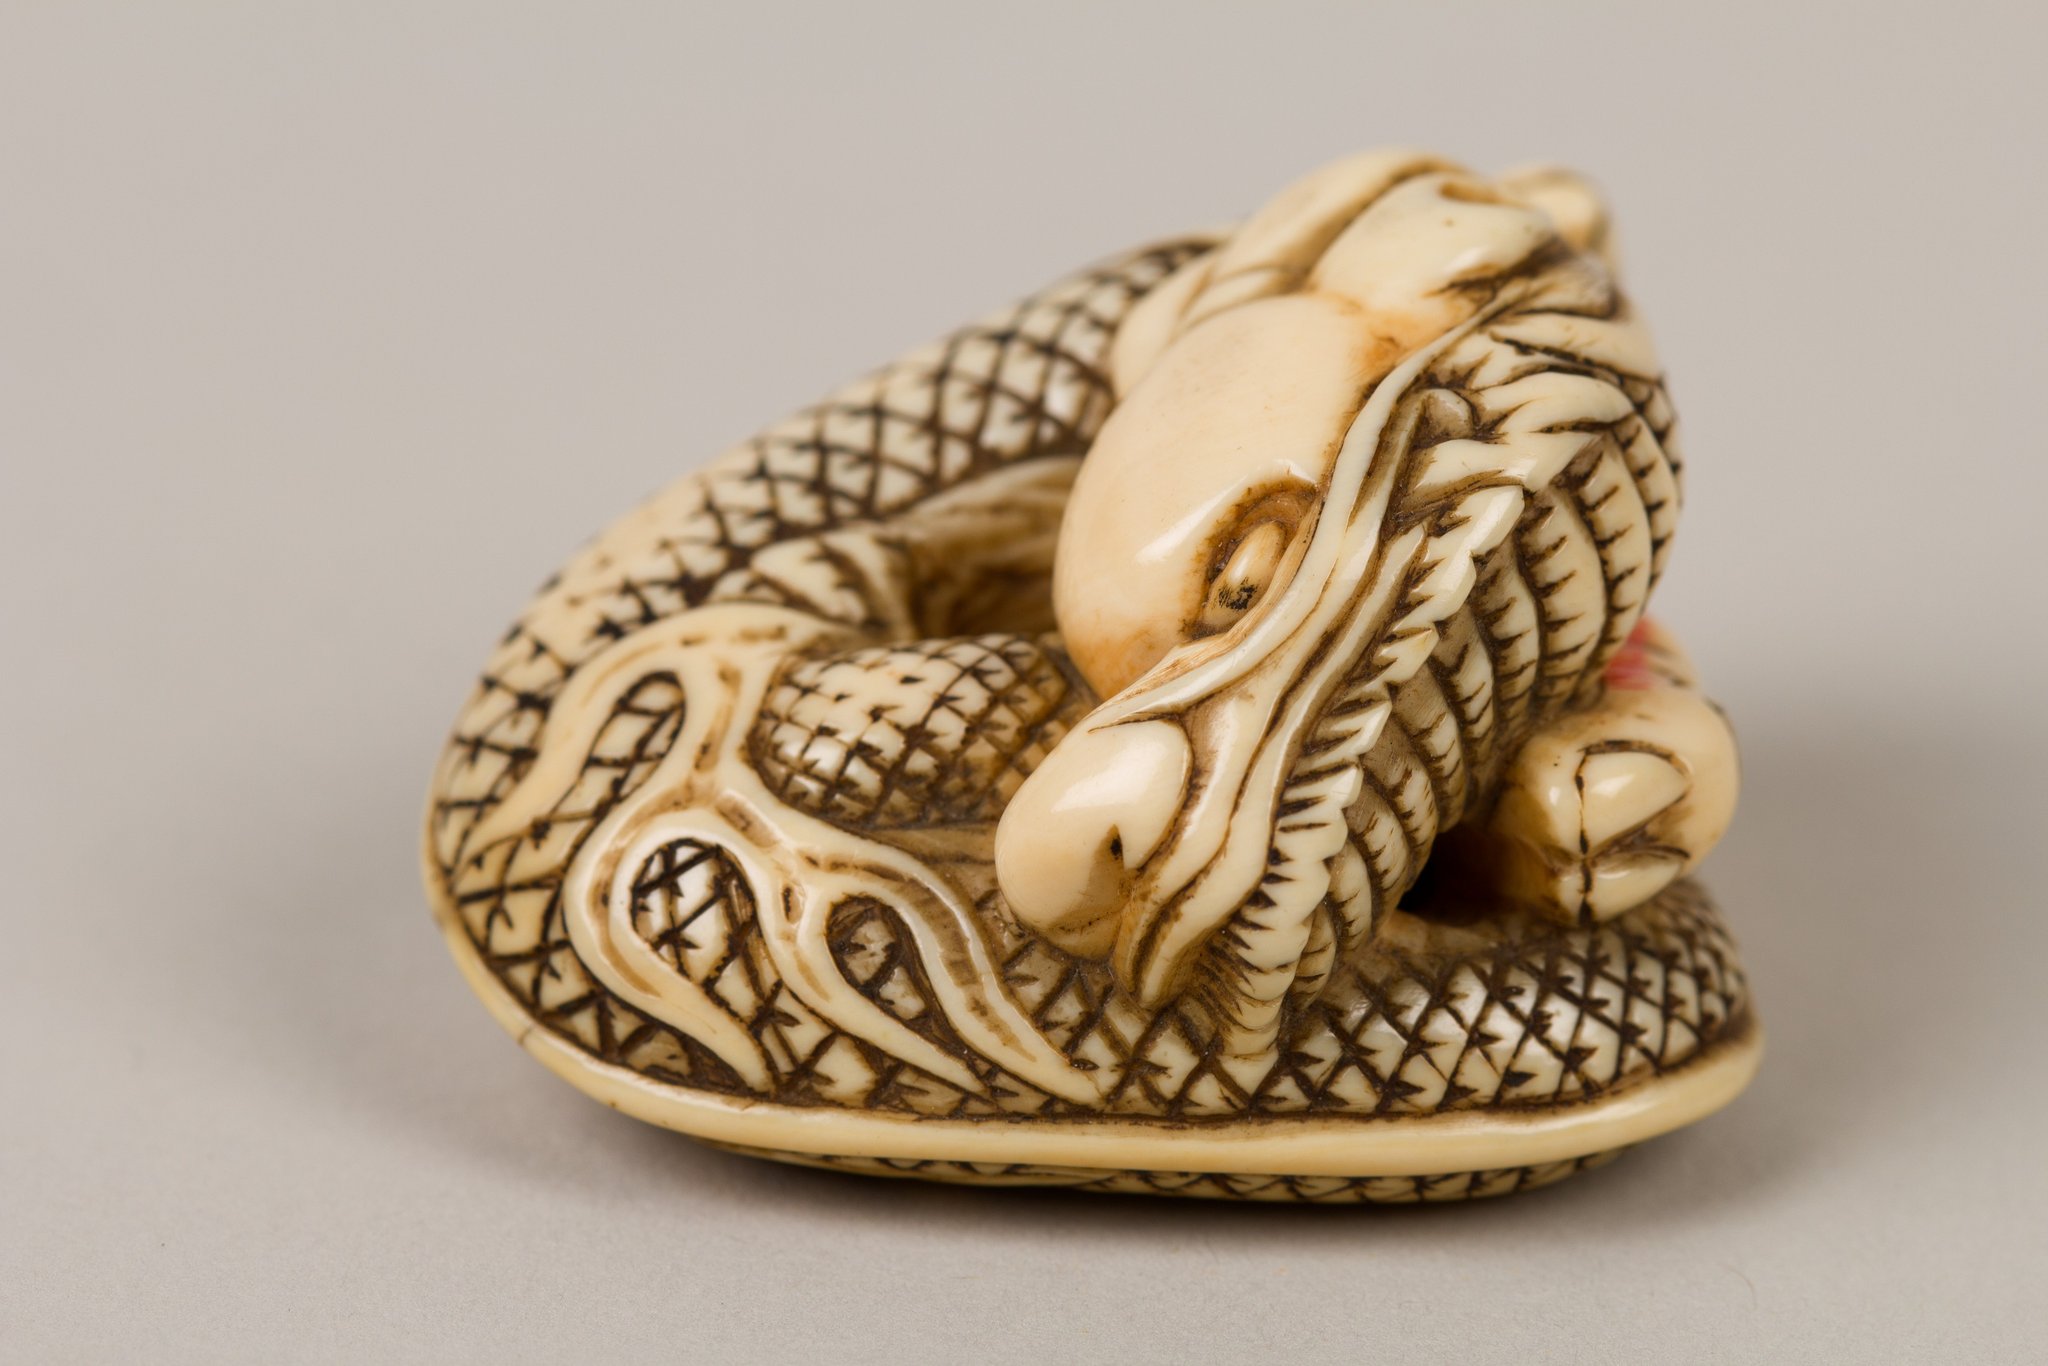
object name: netsuke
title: Netsuke of Coiled Dragon Enclosing a Pearl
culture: japanese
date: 1767-1800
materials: ivory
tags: dragons